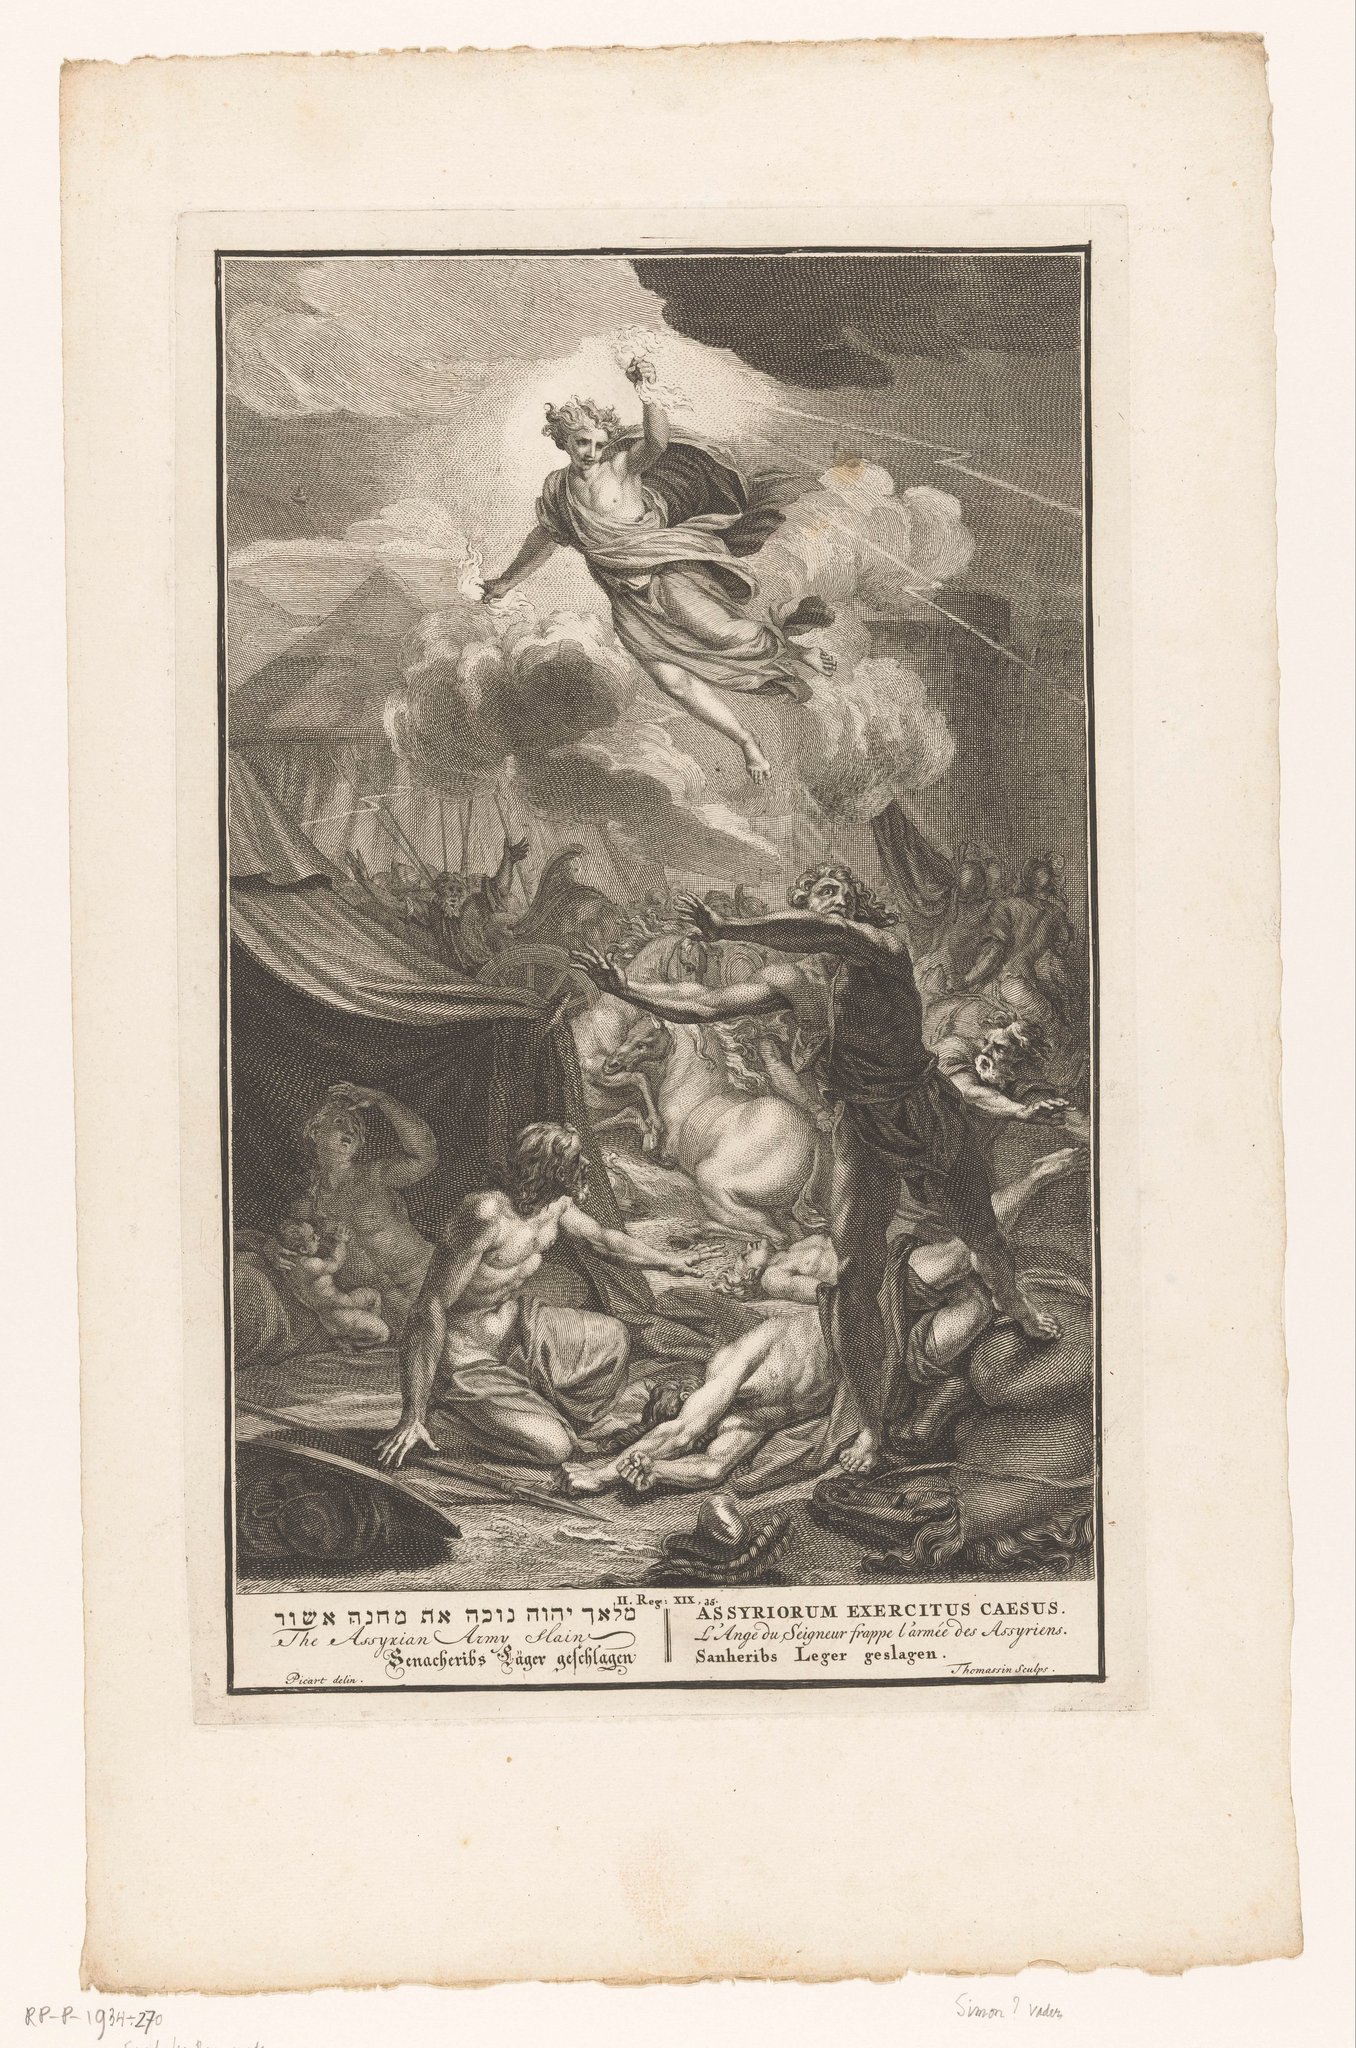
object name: print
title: Sanherib's leger verslagen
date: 1697-1741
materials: paper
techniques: engraving, etching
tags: at night, an angel of the lord decimates the assyrian camp: 185.000 soldiers are killed, tent-camp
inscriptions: collector's mark: Lugt 2228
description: Een engel van God, met in iedere hand een bundel vuur, vliegt boven het tentenkamp van het Assyrische leger waarin vrouwen, soldaten en paarden in paniek vluchten.